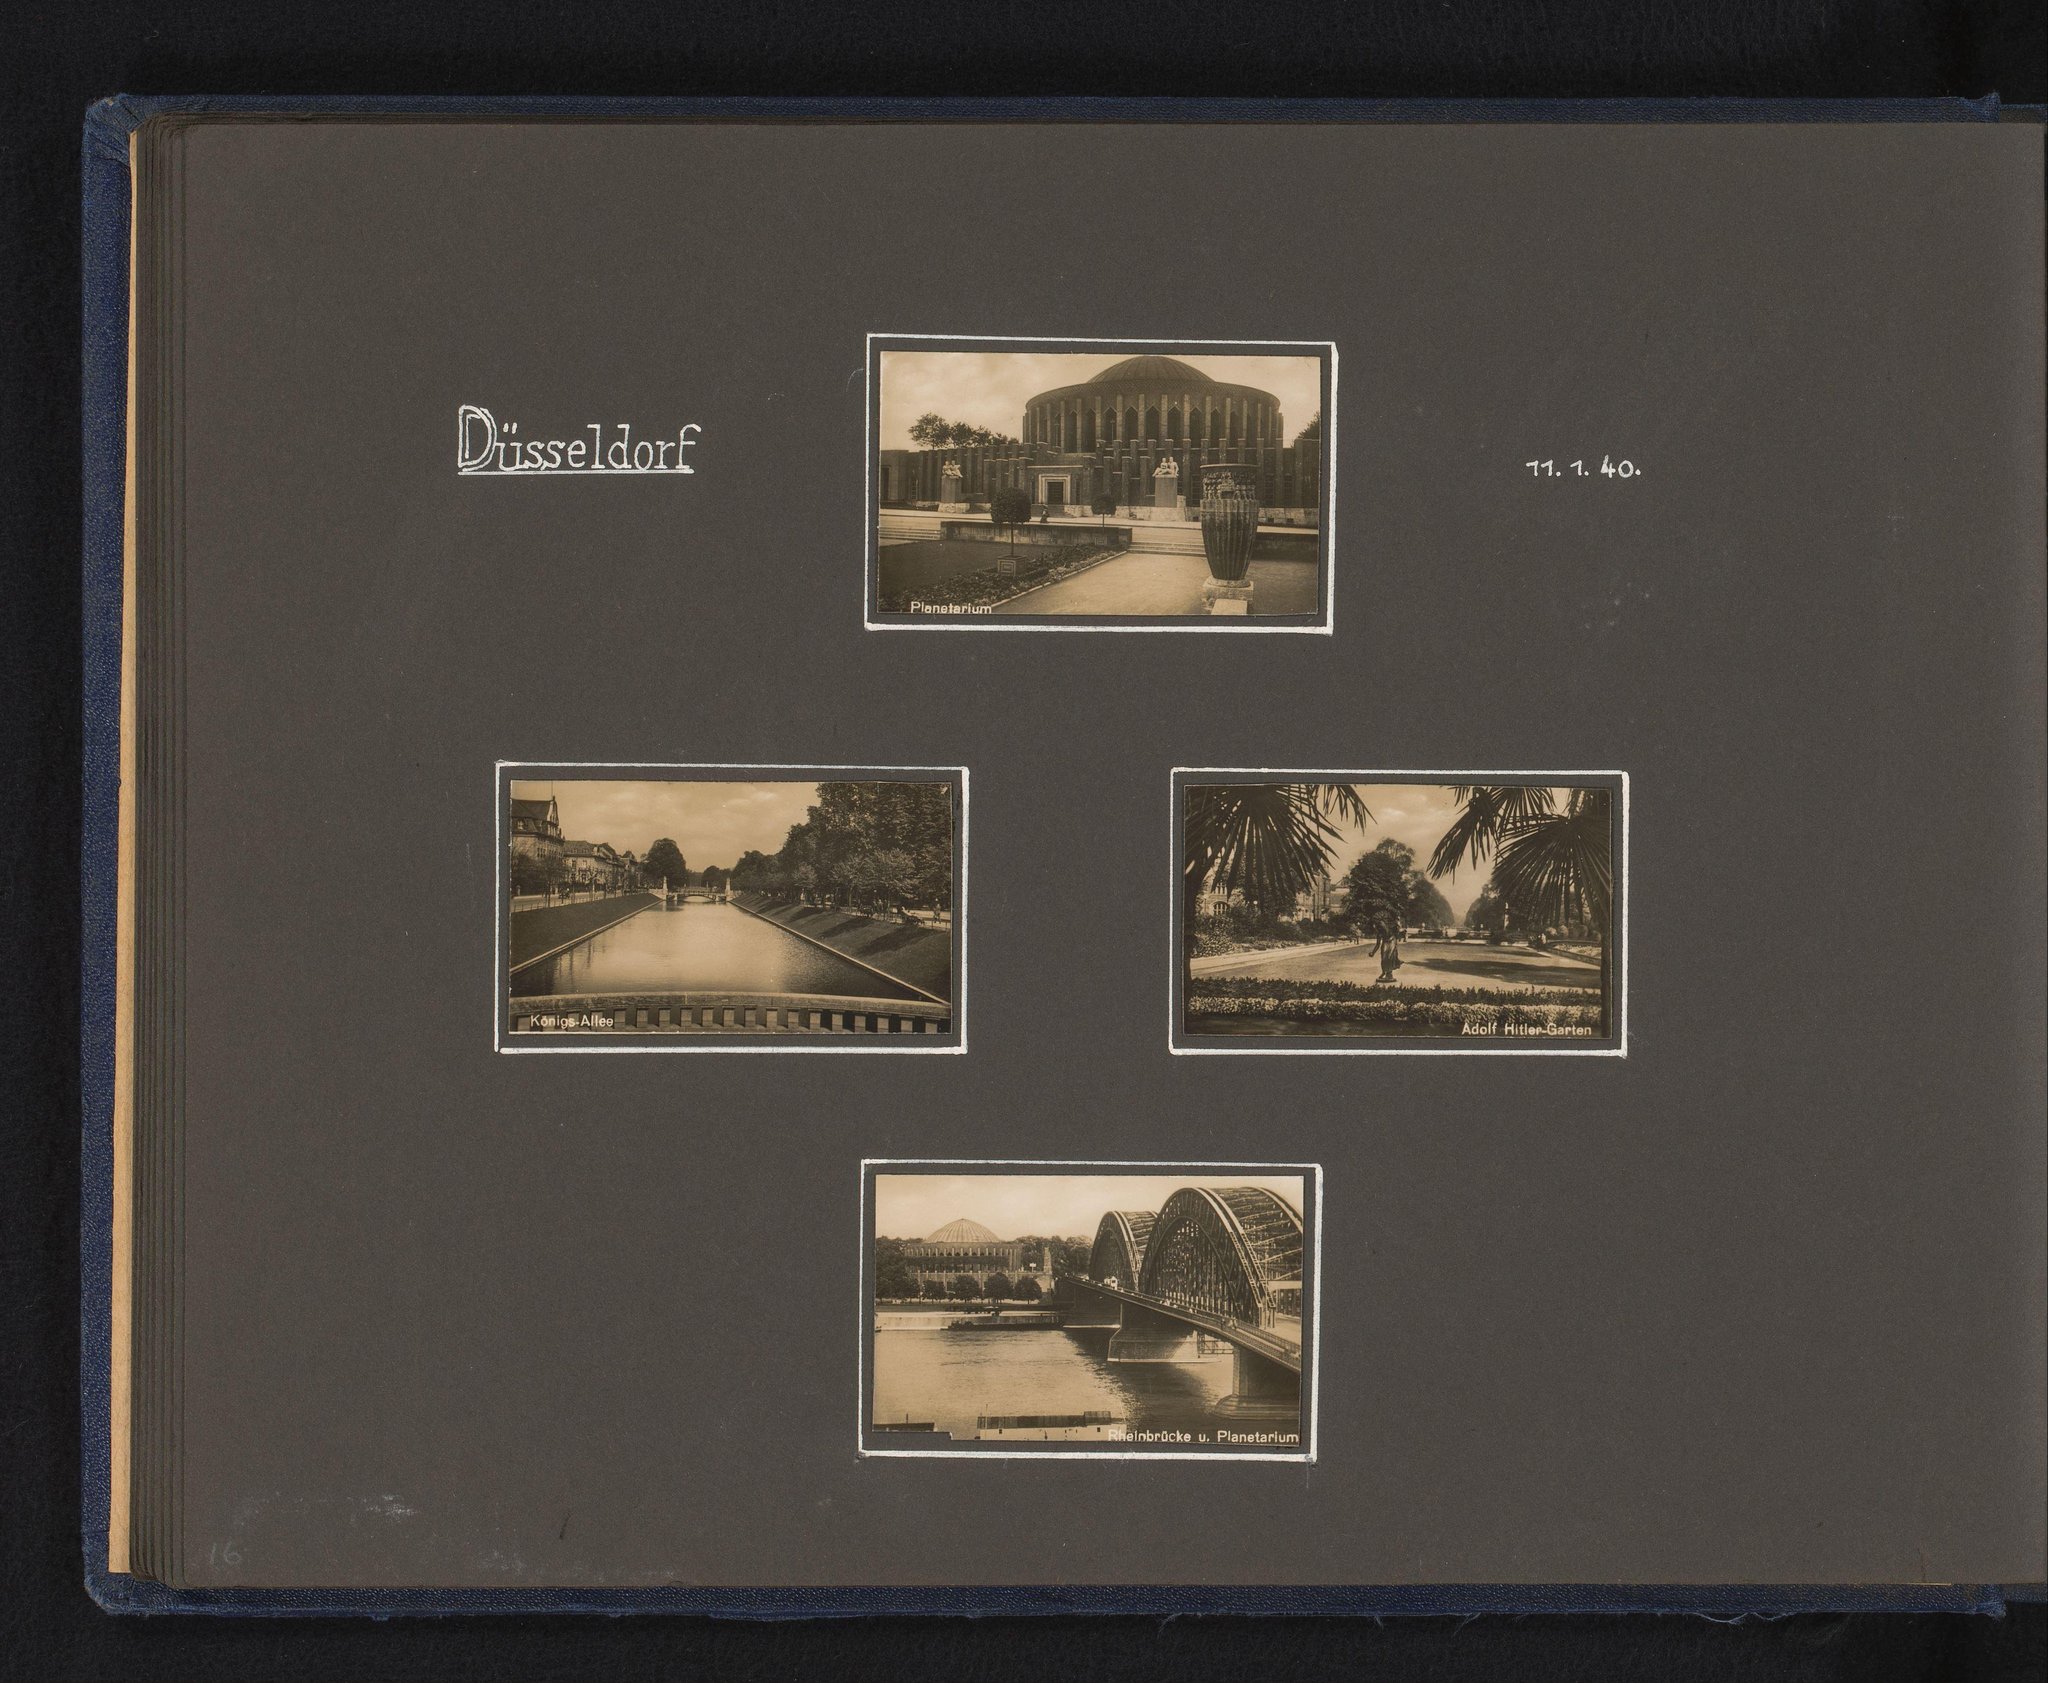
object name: photograph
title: Düsseldorf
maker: Anonymous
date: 1940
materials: paper, photographic support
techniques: gelatin silver print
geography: dusseldorf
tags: city-view in general; 'veduta', germany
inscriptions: inscription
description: Albumblad met vier (gekochte) foto's van bezienswaardigheden in Düsseldorf, waaronder de 'Adolf Hitler-Garten', januari 1940. Onderdeel van een Duits militair album Tweede Wereldoorlog 1939-1940.